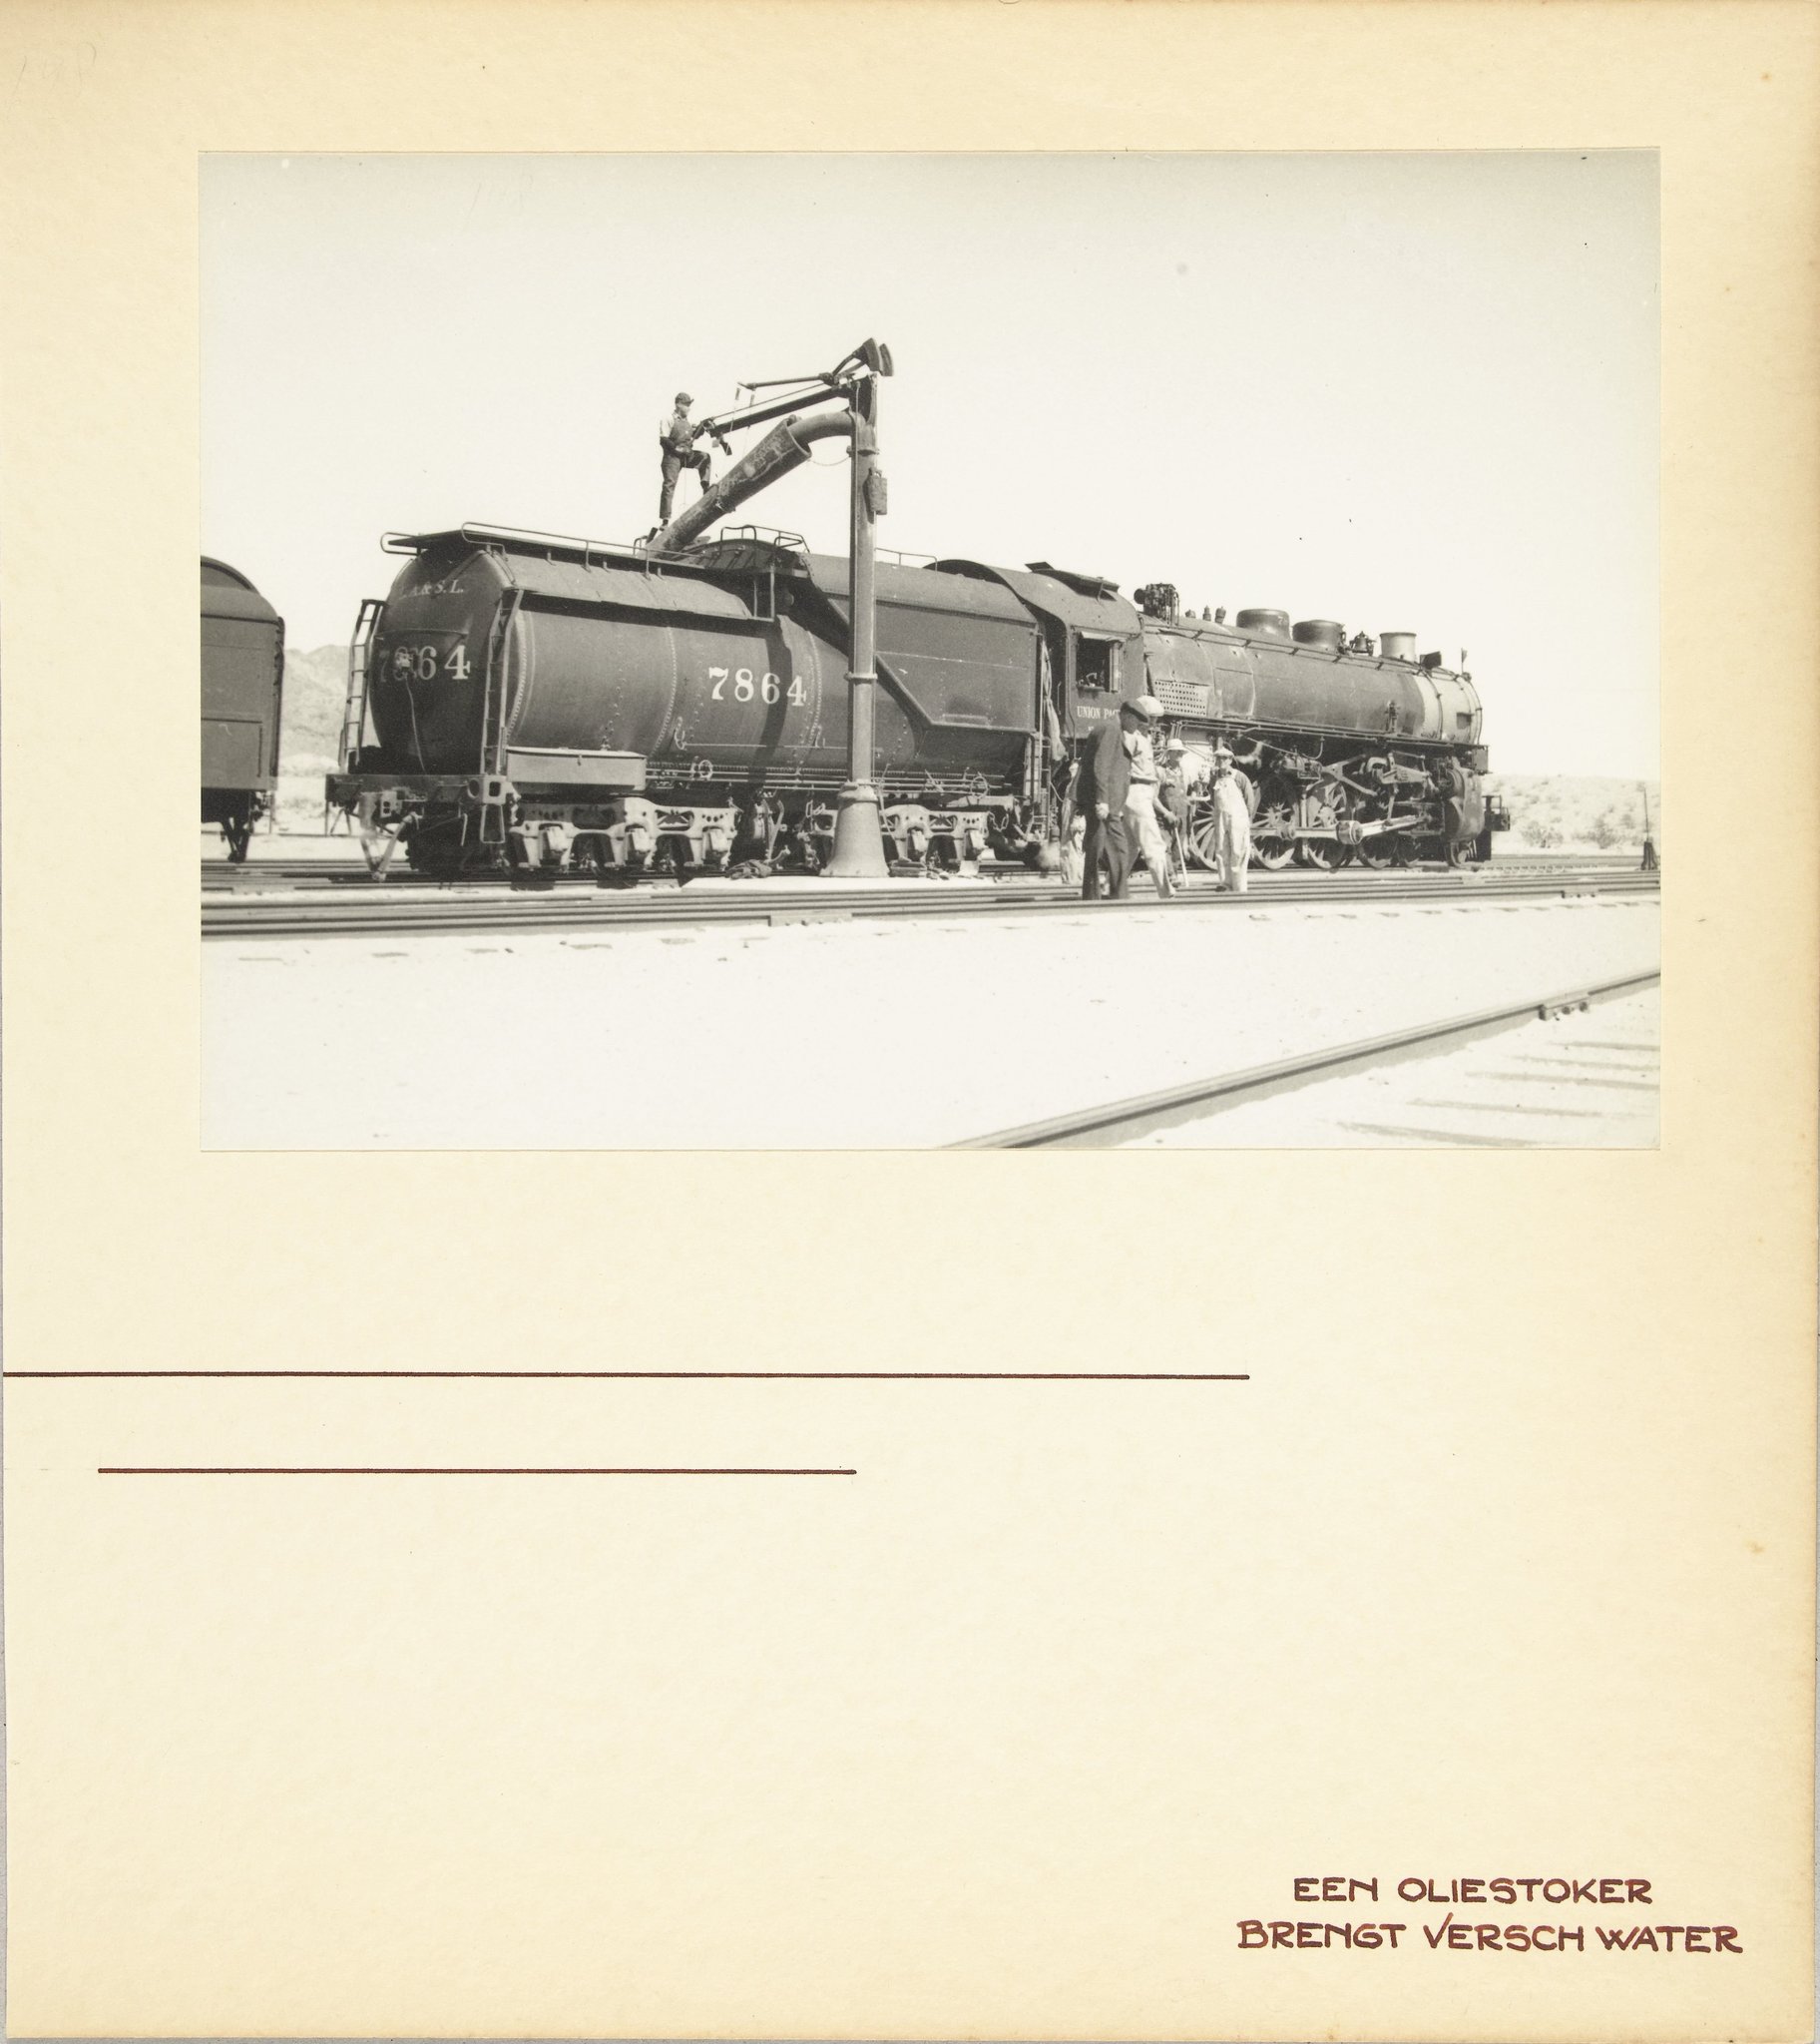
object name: photograph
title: Een oliestoker brengt versch water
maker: wouter cool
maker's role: engineer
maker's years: 1877-1947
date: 1936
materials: cardboard, paper, photographic support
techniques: gelatin silver print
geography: united states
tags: locomotive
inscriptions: title: ‘EEN OLIESTOKER / BRENGT VERSCH WATER’